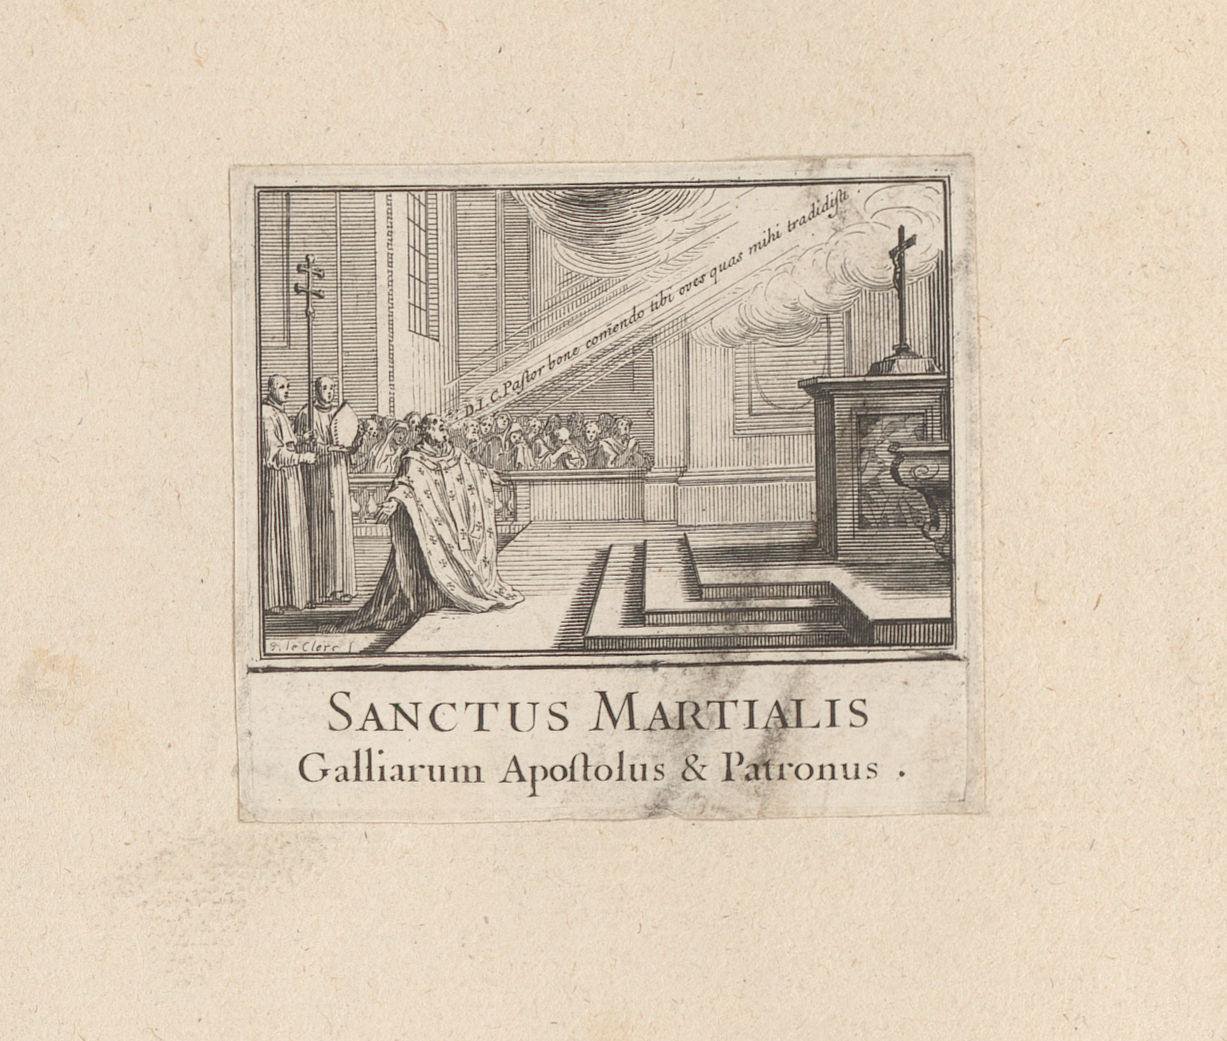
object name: album leaf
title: H. Martialis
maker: sébastien leclerc (i)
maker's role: print maker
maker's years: 1637-1714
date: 1694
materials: paper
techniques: etching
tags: martial(is), bishop of limoges; possible attributes: staff